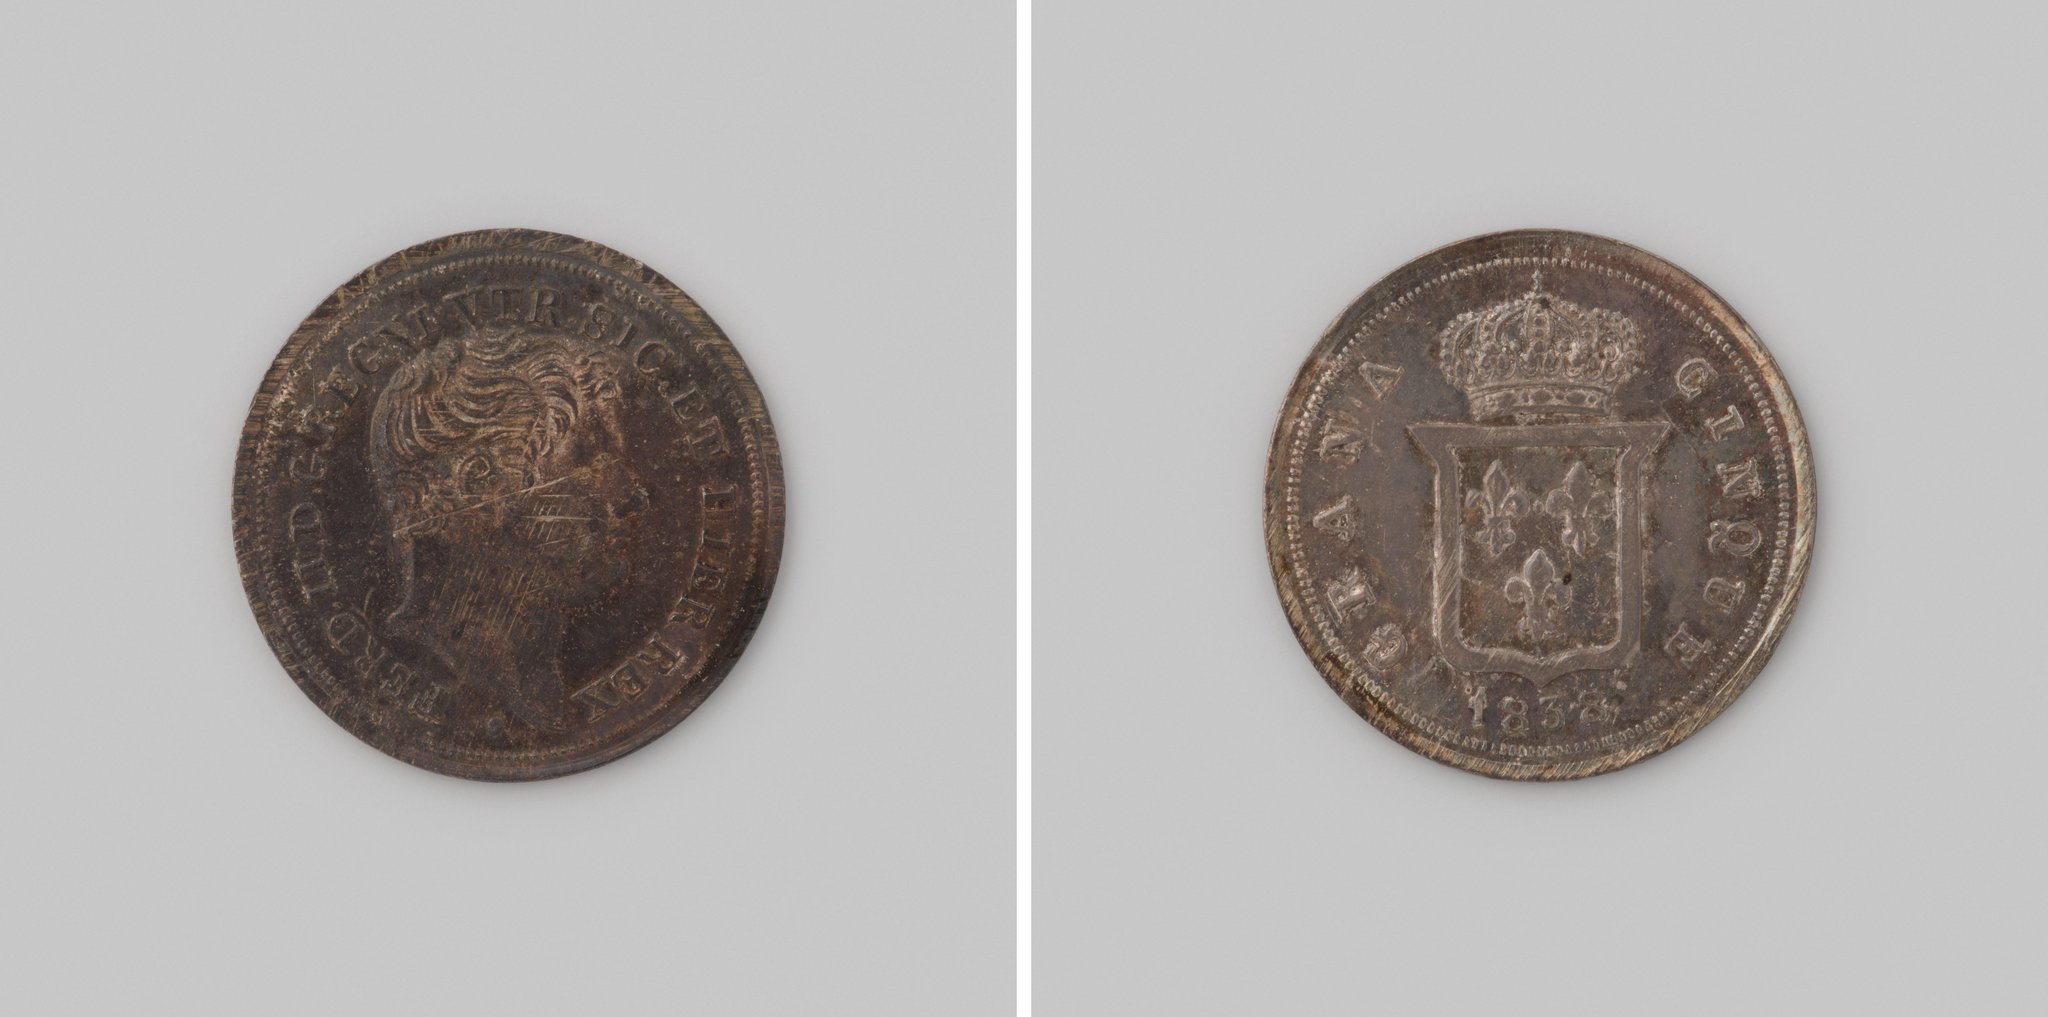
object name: coin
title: Koninkrijk Napels van de beide Siciliën, Ferdinando II, 5 grani, 1838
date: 1838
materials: silver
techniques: striking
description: Zilveren munt. Voorzijde: hoofd naar rechts. Keerzijde: gekroond wapenschild van Bourbon. Waarde-aanduiding: Grana cinque in het omschrift. Jaaartal onderaan. Gladde rand.